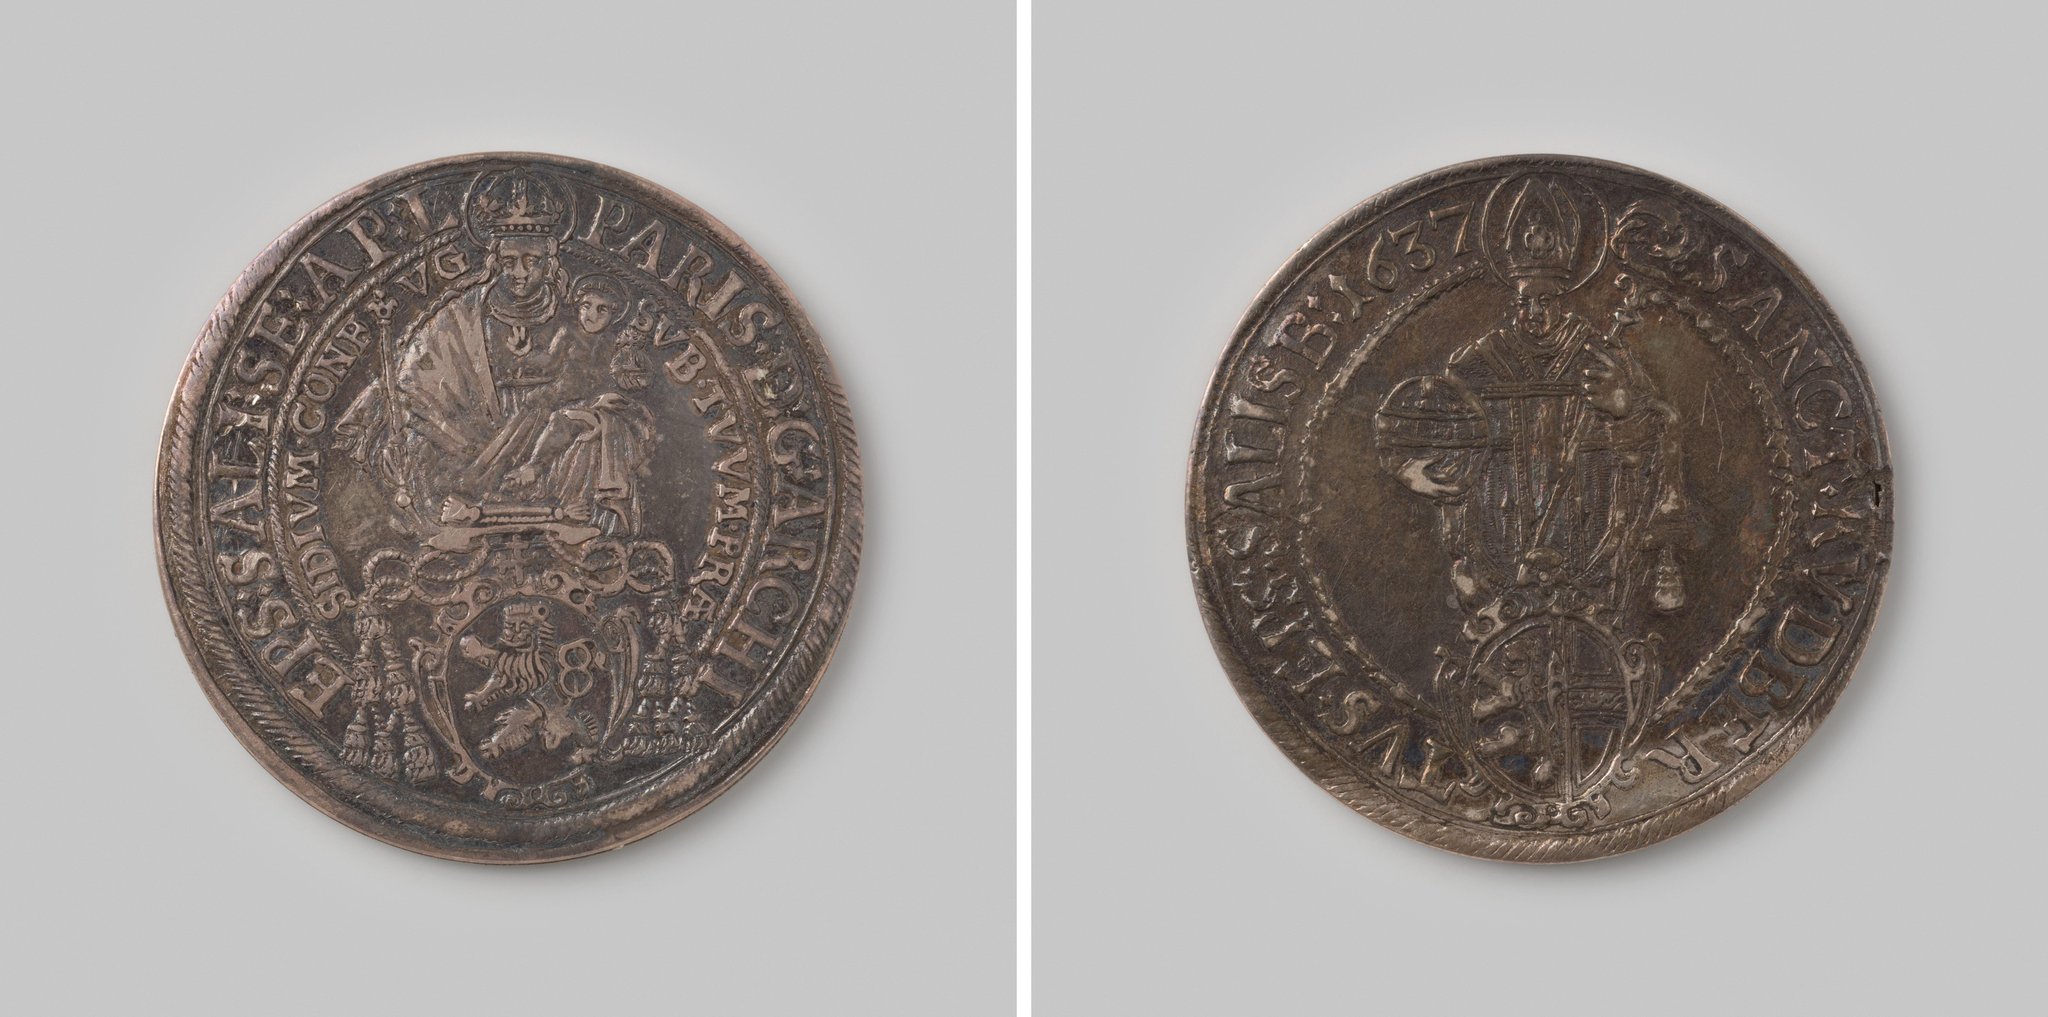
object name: coin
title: Taler uit het aartsbisdom Salzburg van Paris von Lodron,1637. Schroefthaler.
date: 1637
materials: silver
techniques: striking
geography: salzburg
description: Zilveren munt, waarvan muntplaatje is uitgehold en van schroefdraad voorzien. zogenaamde schroefthaler. In binnenruimte 10 gekleurde mica plaatjes. Voorzijde: zittende madonna, in haar linkerhand rijksappel en in haar rechter scepter. Daaronder versierd wapenschild, waarboven kruis met de hoed van de aarstbisschop. Dubbel omschrift. Keerzijde: staande bisschop met mijter en staf met aan zijn voeten versierd wapenschild. Jaartal aan het eind van het omschrift.